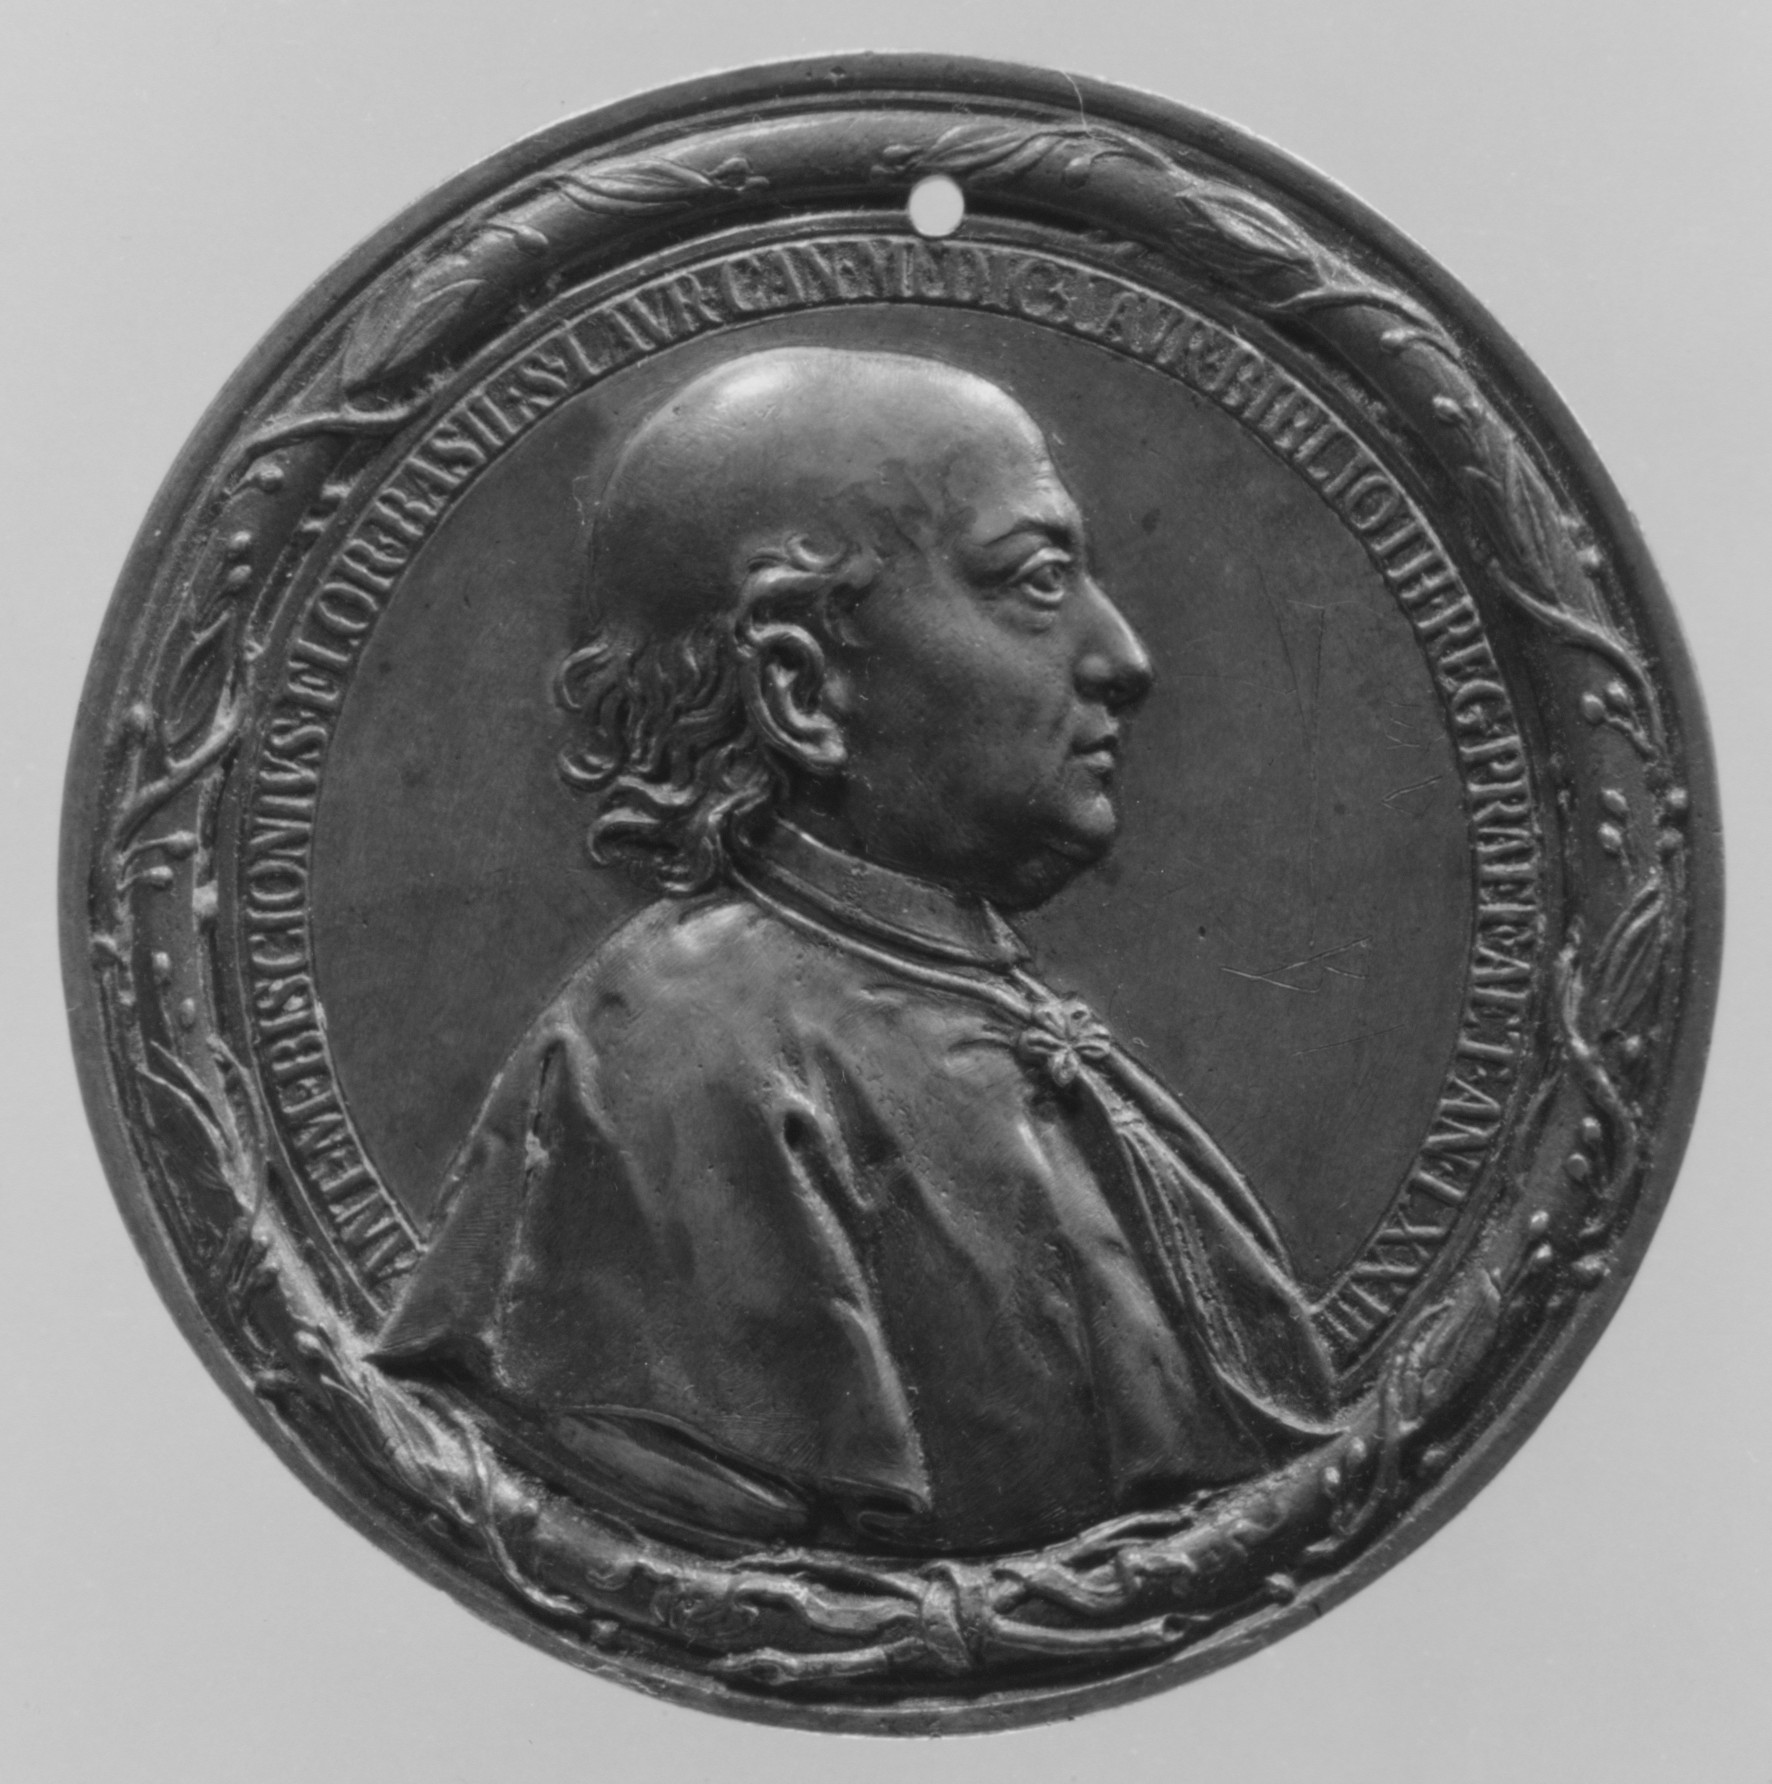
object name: medal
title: Antonio Maria Biscioni (1674–1756)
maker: lorenzo maria weber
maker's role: artist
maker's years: 1692-1764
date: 1747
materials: bronze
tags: men,profiles